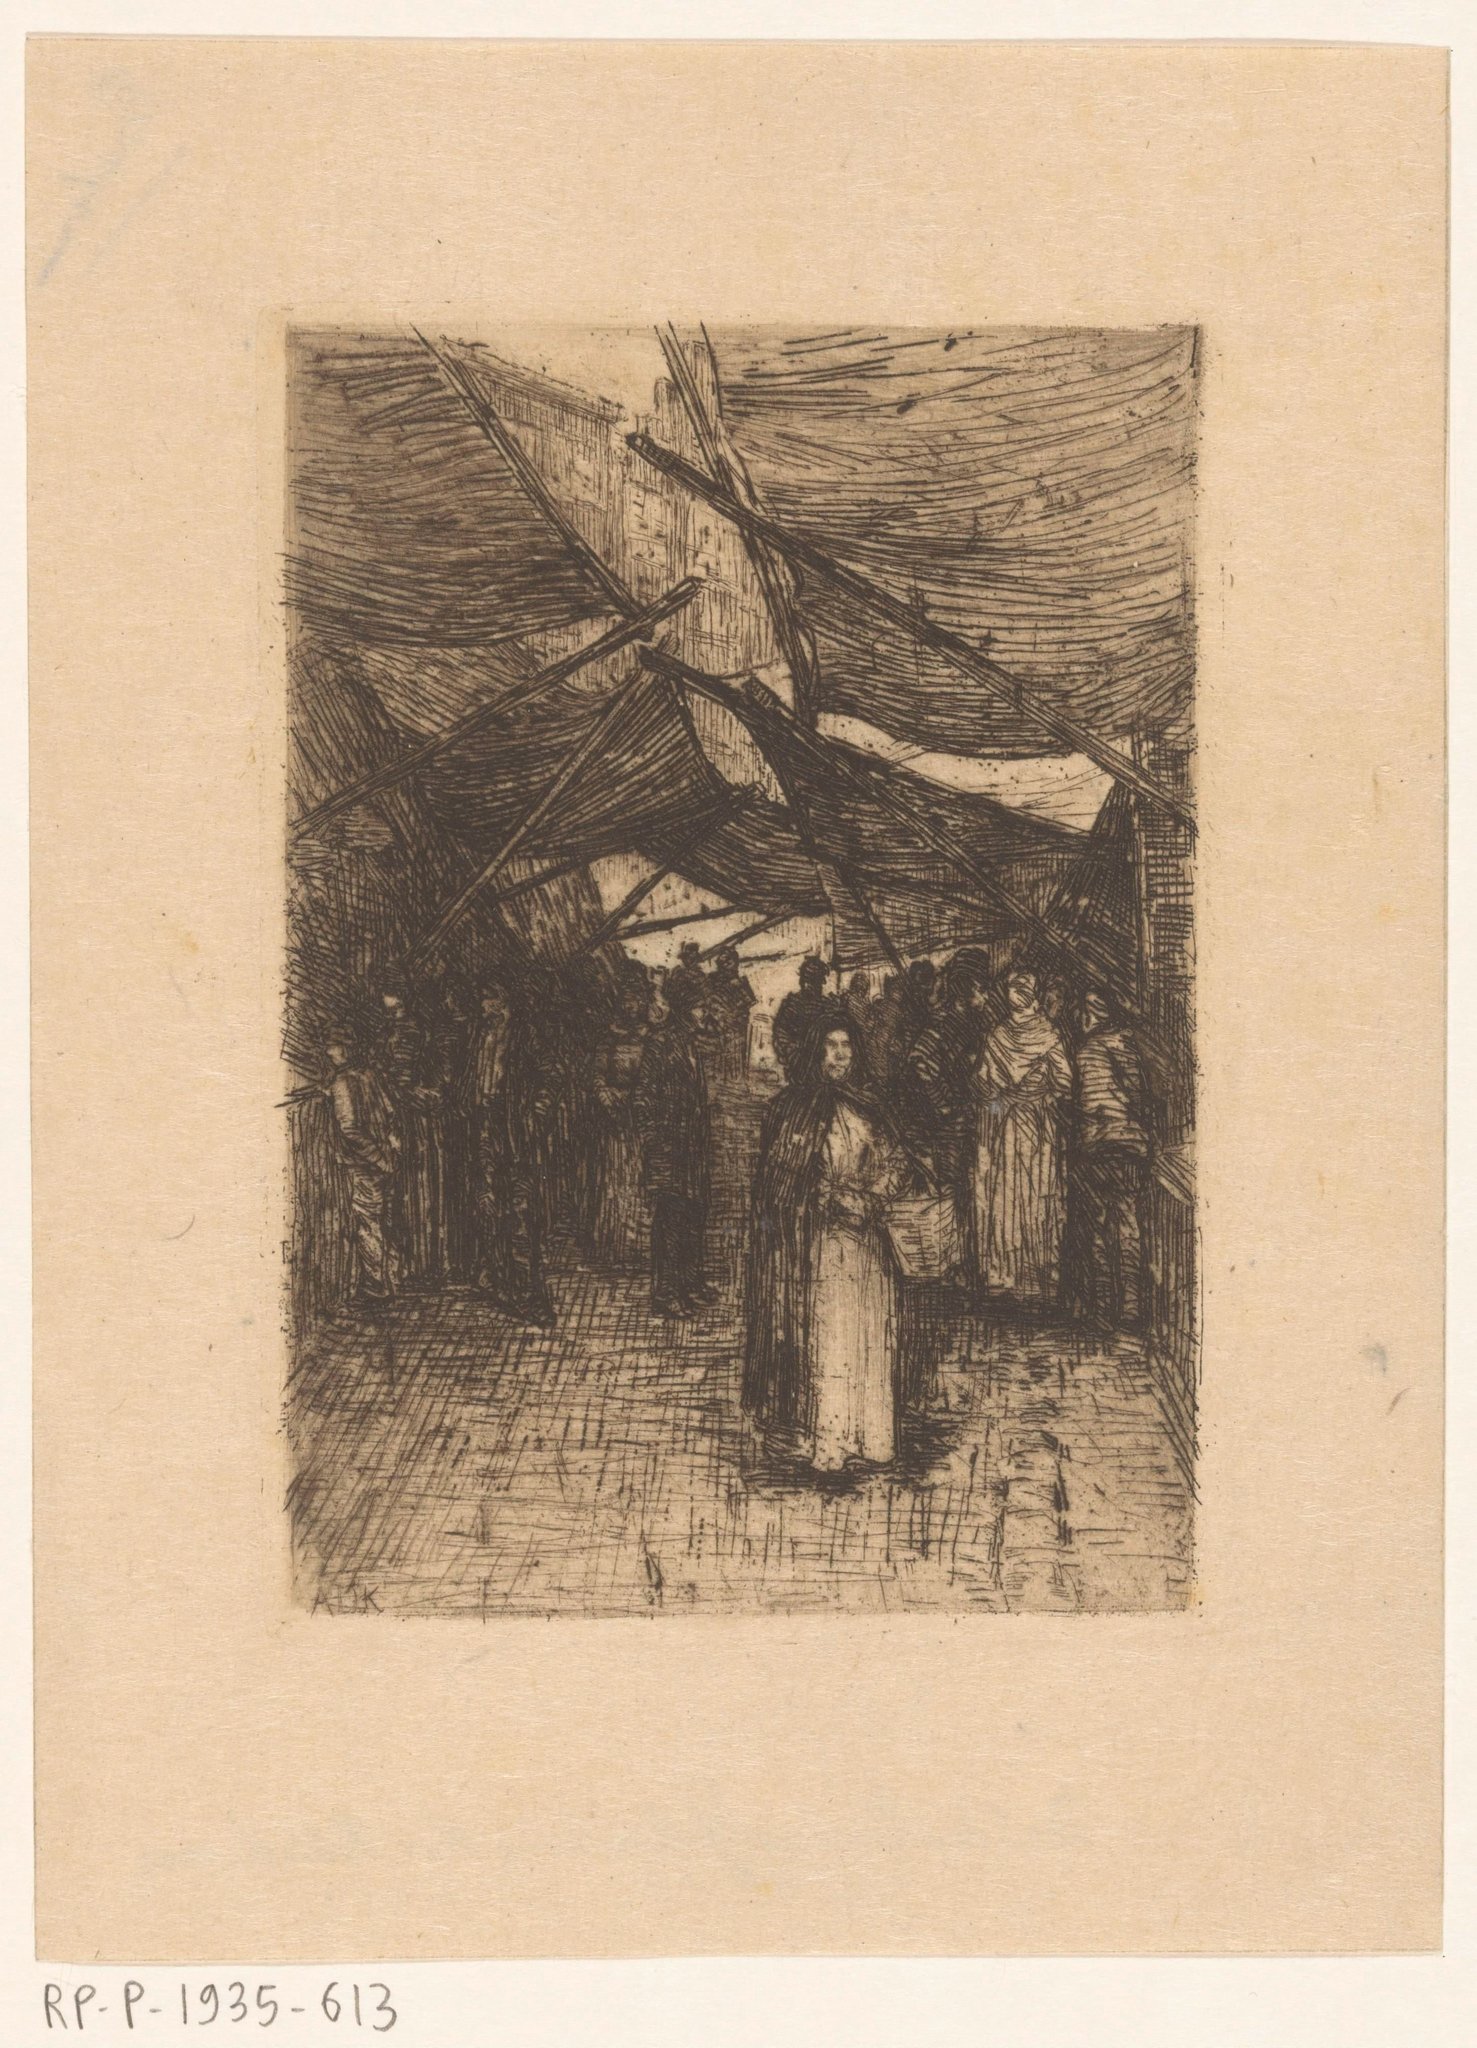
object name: print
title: Tussen de kramen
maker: antoon derkinderen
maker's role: draughtsman, painter, print maker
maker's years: 1859-1925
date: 1886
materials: paper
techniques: etching, intaglio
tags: market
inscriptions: collector's mark: Lugt 2228, collector's mark: Lugt 2760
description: Prent afkomstig uit de Portefeuille der Nederlandsche Etsclub, eerste jaargang, 1886.